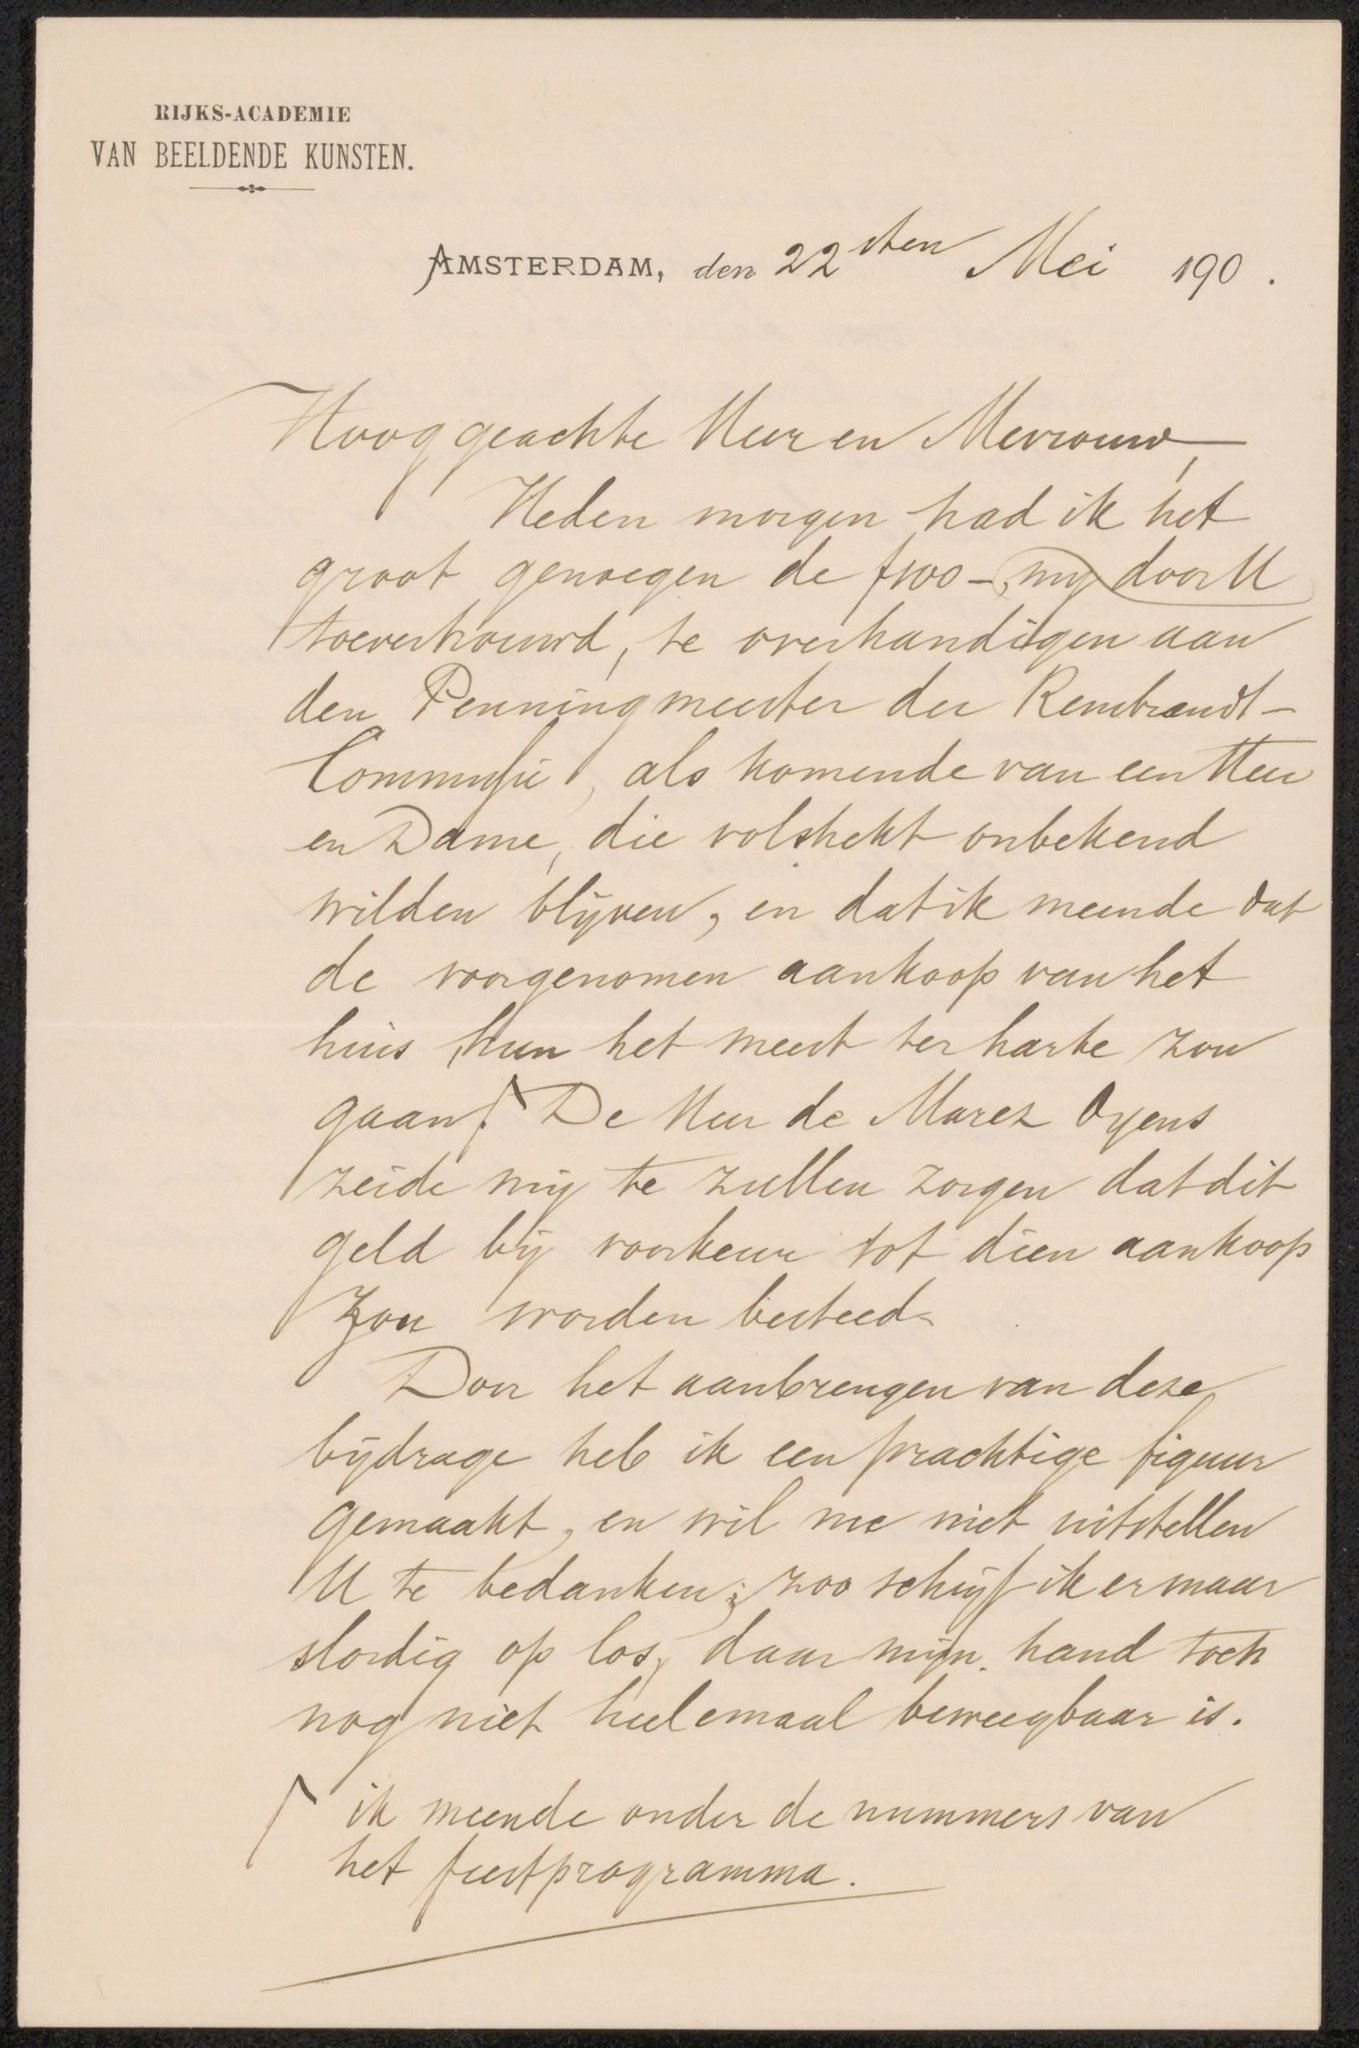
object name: letter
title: Brief aan Max Wilhelm Carl Weber en Anne Antoinette Weber-Van Bosse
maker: august allebé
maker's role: draughtsman, print maker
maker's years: 1838-1927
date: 1900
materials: ink, paper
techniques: pen, printing, writing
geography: amsterdam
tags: anne antoinette weber-van bosse, painter, money